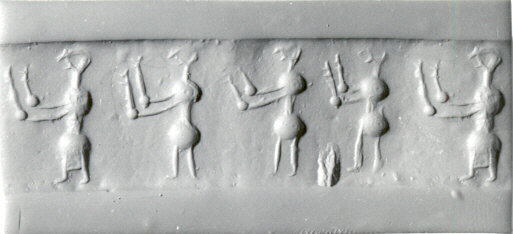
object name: cylinder seal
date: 3100-2900 BCE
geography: mesopotamia